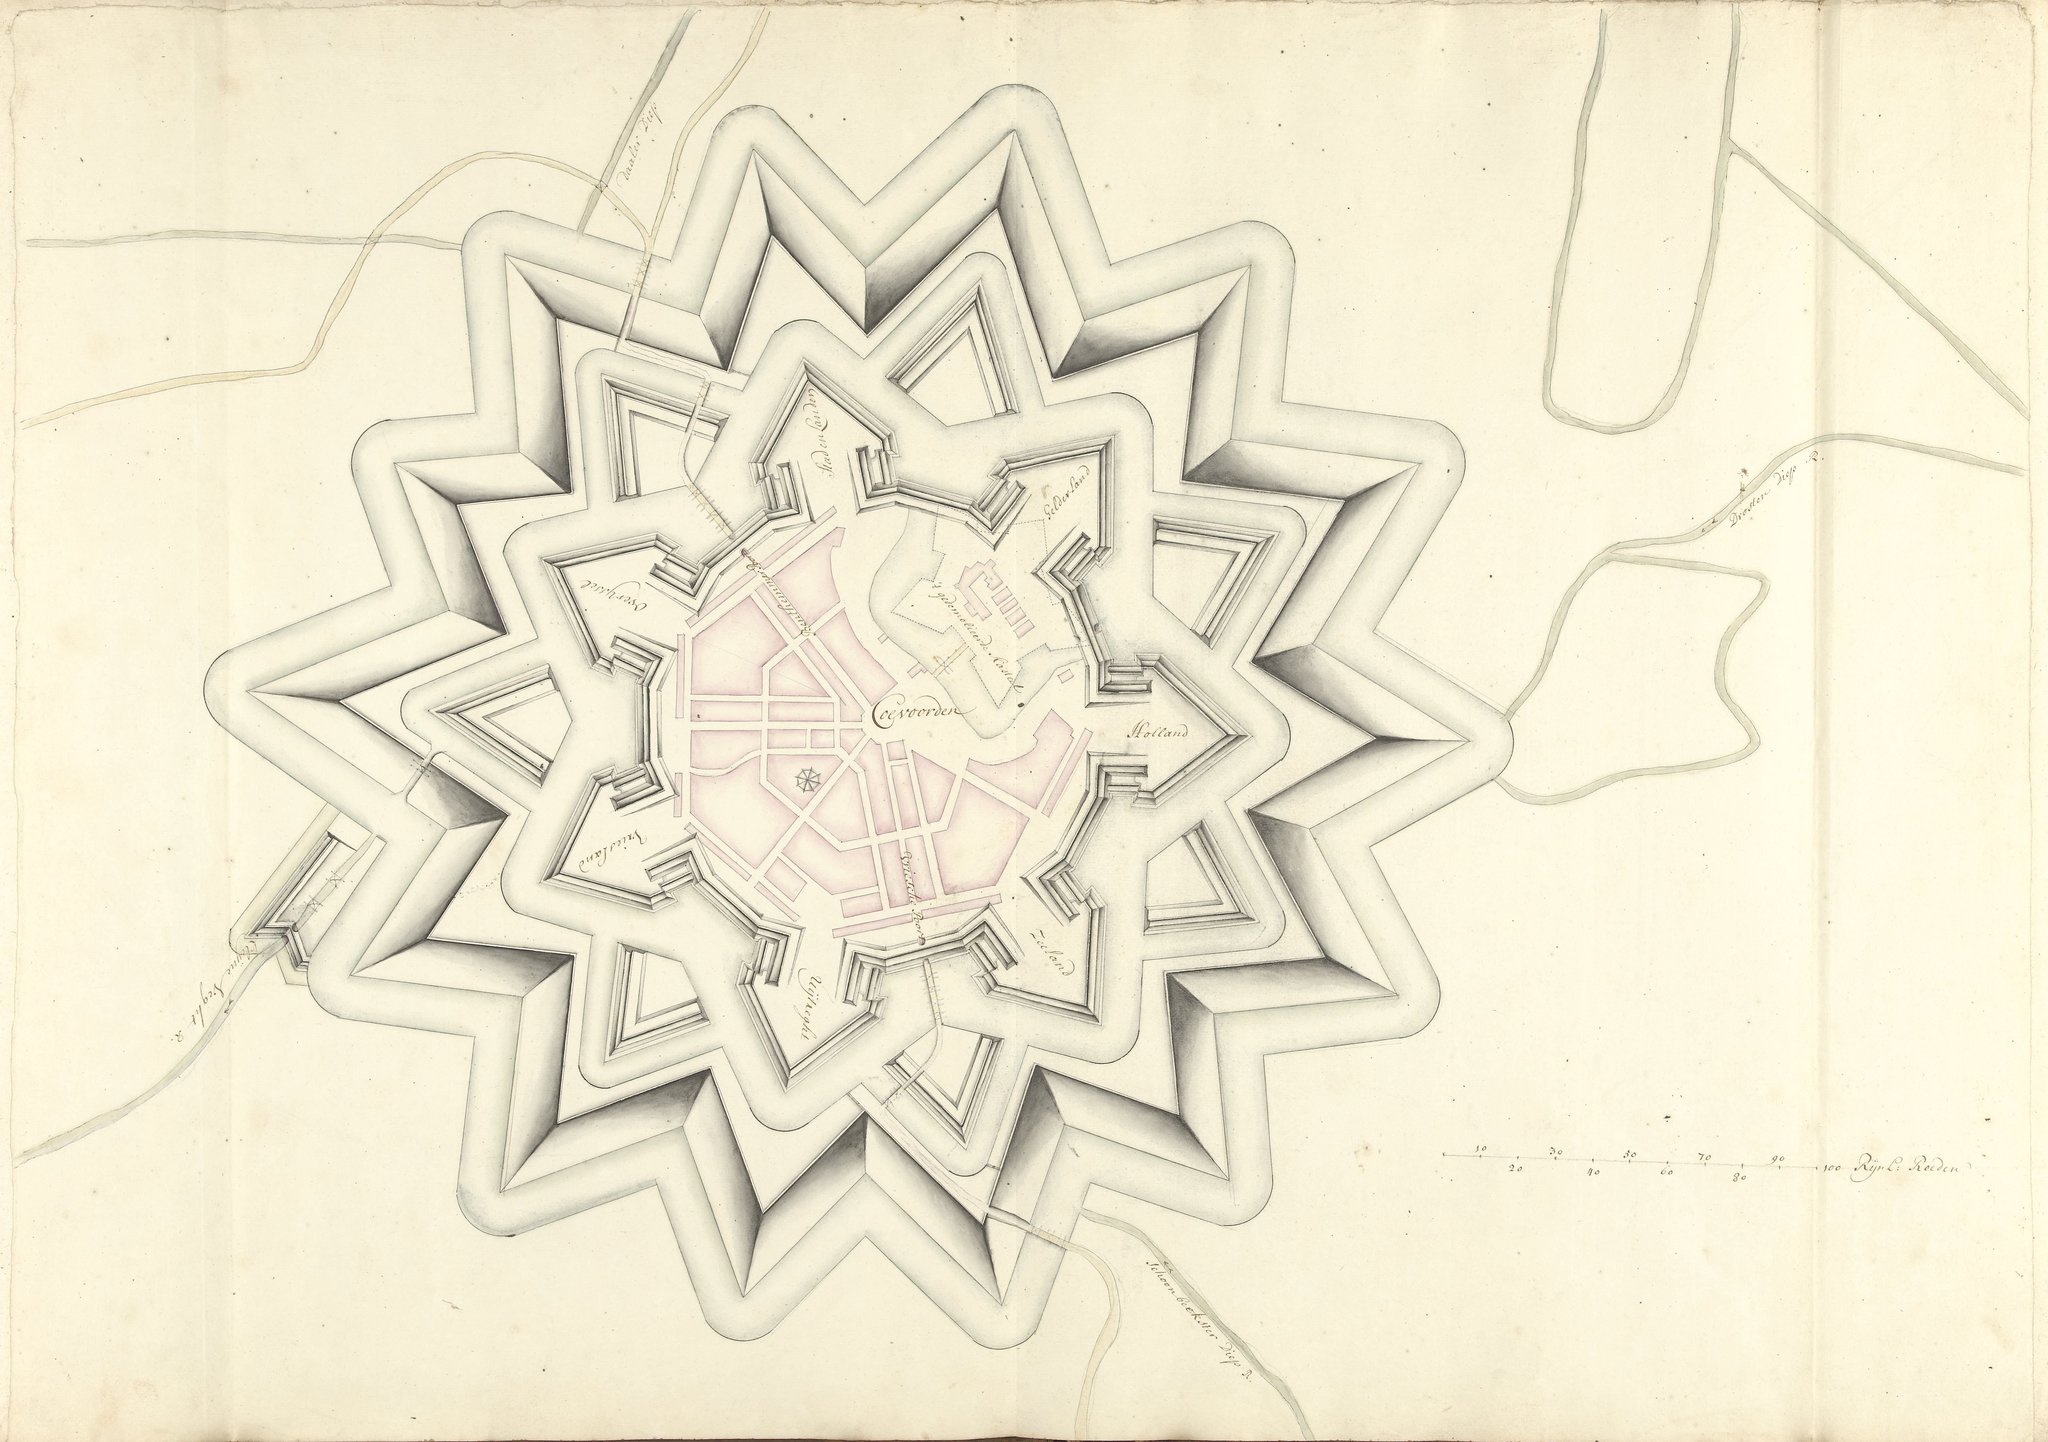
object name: drawing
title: Plattegrond van Coevorden, ca. 1701-1715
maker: samuel du ry de champdoré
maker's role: draughtsman, engineer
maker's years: 1651-1729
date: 1701-1715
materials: paper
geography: netherlands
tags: fortress, maps of cities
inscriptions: collector's mark: Lugt 2166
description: Plattegrond van de versterkingen om de stad Coevorden, ca. 1701-1715. Onderdeel van een verzameling getekende plannen van versterkte plaatsen in Nederland en omringende landen ten tijde van de Spaanse Successieoorlog (deel B).